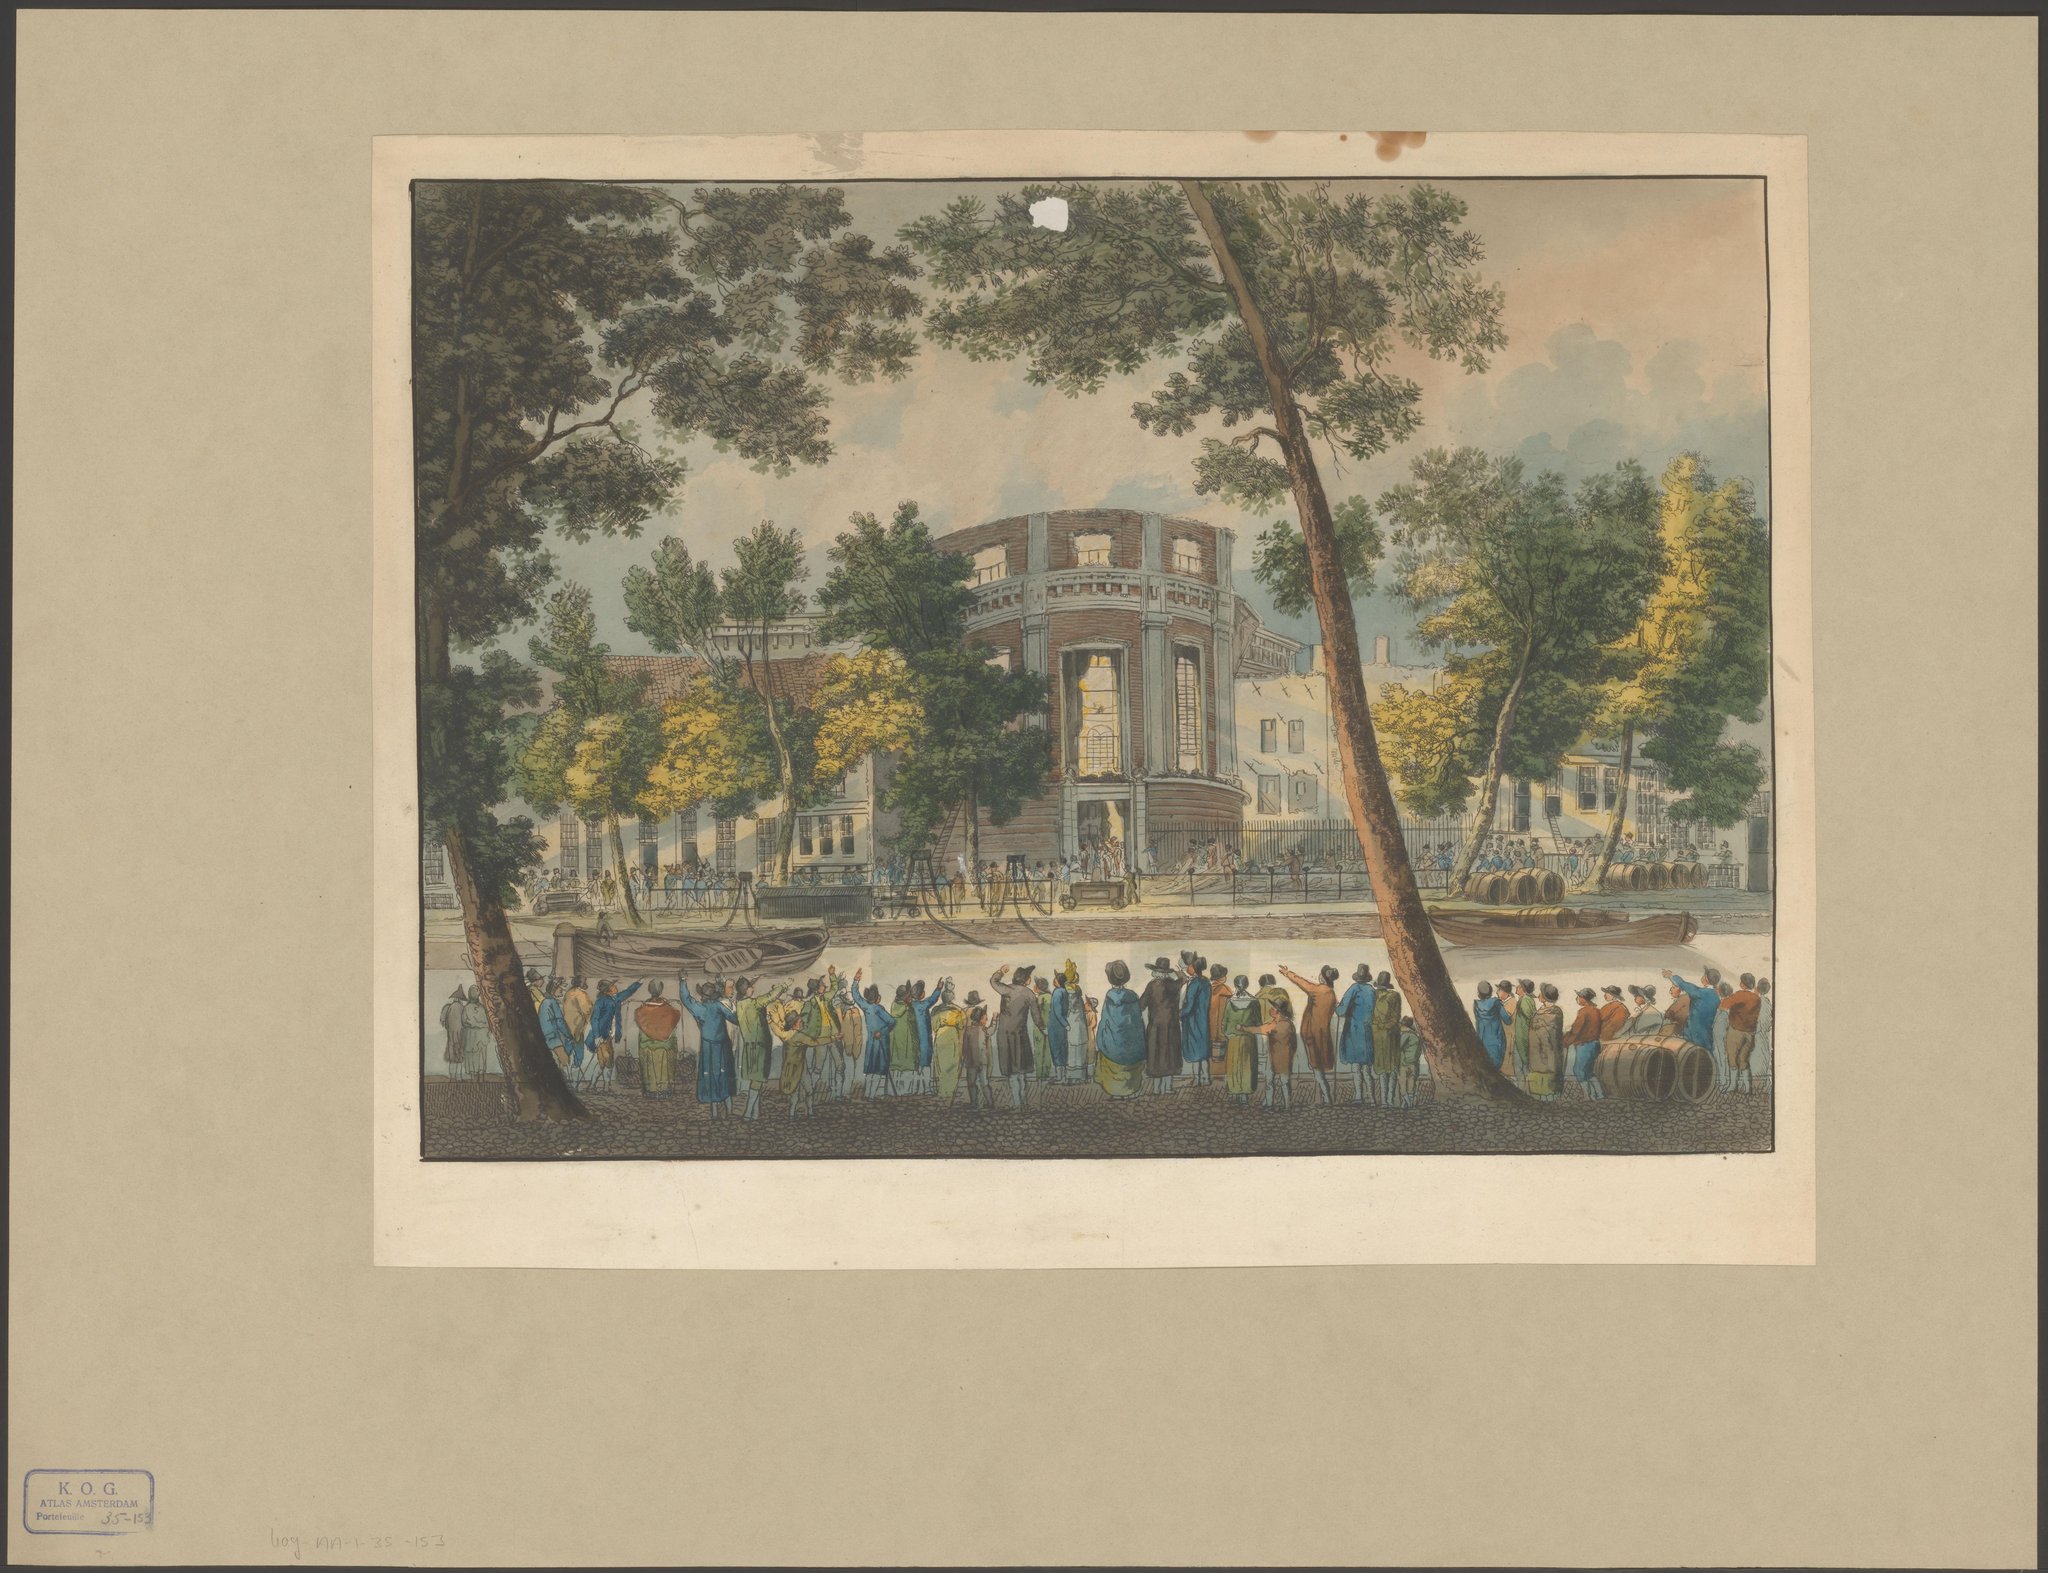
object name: print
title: Gezicht op de ruïne Nieuwe Lutherse Kerk op het Singel te Amsterdam, 1822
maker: Anonymous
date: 1822-1823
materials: paper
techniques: aquatint, etching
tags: on fire, ablaze, ruin of a building ~ architecture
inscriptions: collector's mark: Lugt 1641b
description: Singel 11 gezien naar de oostzijde met Nieuwe Lutherse Kerk, na de brand op 18 september 1822. Onderwerpsrubriek binnen de Atlas Amsterdam: Kerkwezen: Ev. Lutherse Gemeente: 1822 Brand in de Nieuwe Luthersche Koepelkerk - Ruïne.